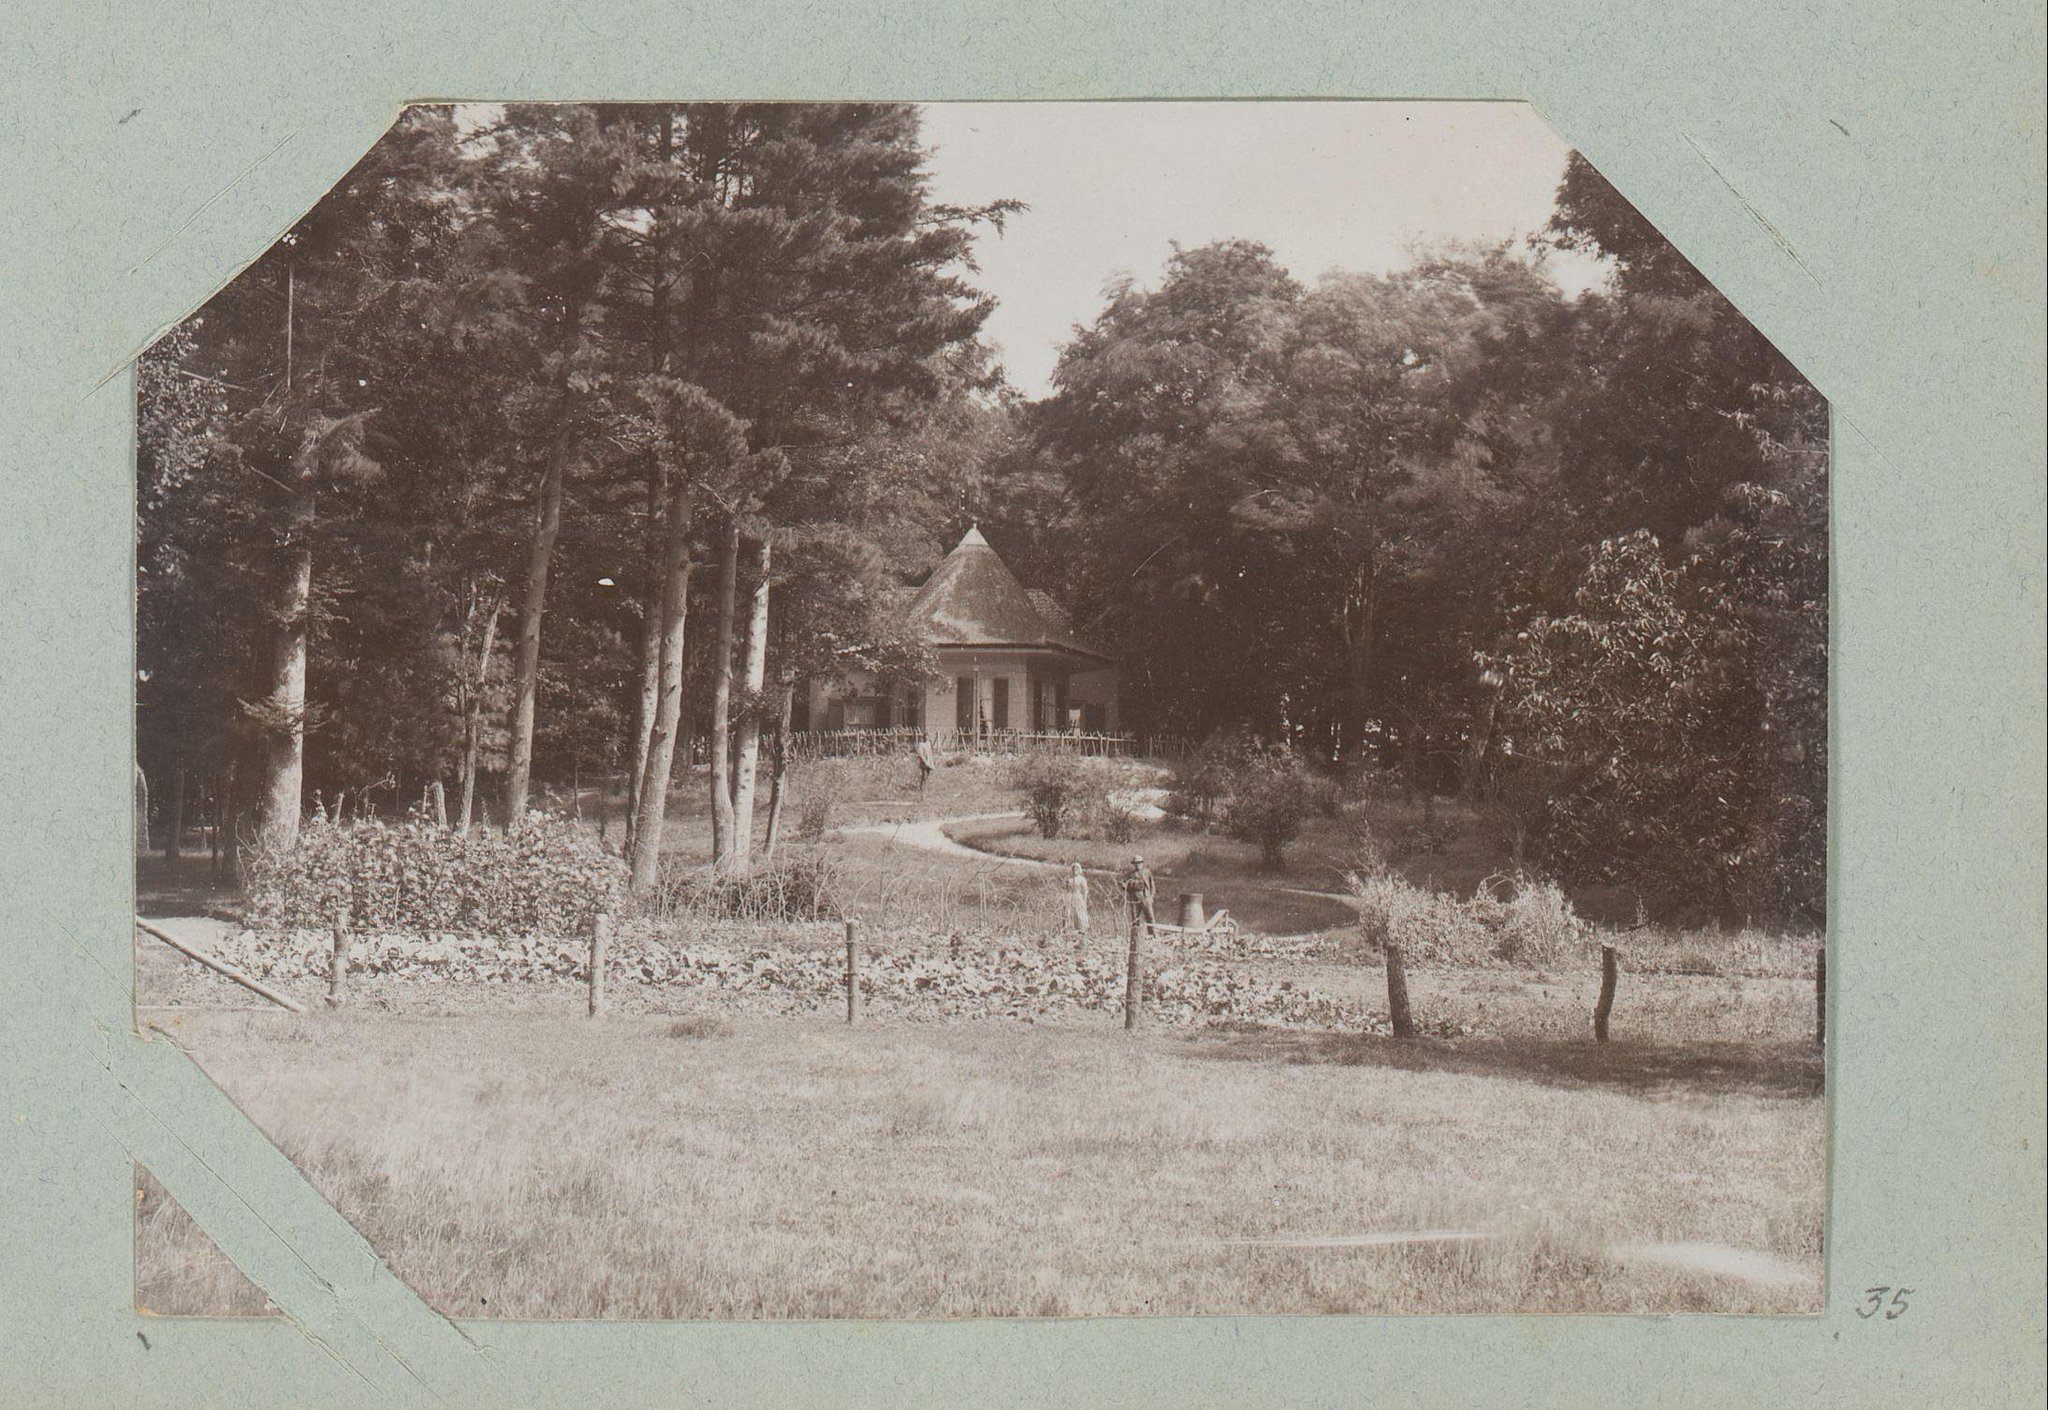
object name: album leaf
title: Huis in een bos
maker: Anonymous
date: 1895-1905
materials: paper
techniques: collodion silver print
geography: netherlands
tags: rural housing, e.g. country-house, villa, cottage, netherlands